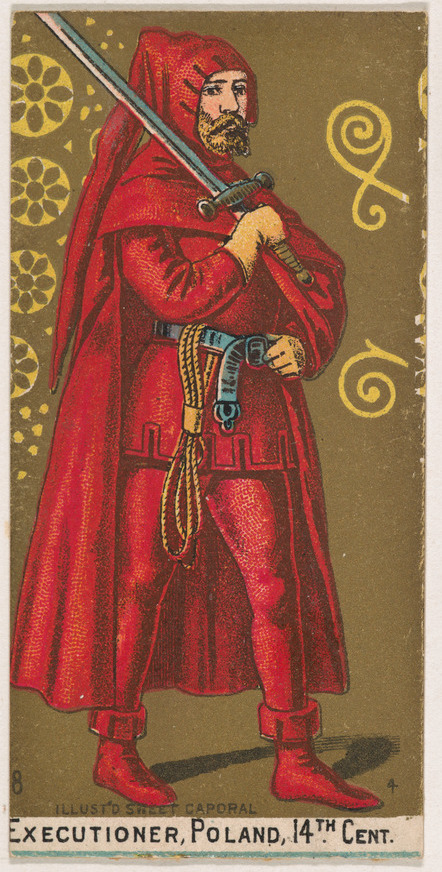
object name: print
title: Executioner, Poland, 14th Century, from the Military Series (N224) issued by Kinney Tobacco Company to promote Sweet Caporal Cigarettes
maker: kinney brothers tobacco company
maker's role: publisher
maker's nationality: american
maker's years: 1869-2011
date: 1888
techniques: color lithograph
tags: military,swords,men